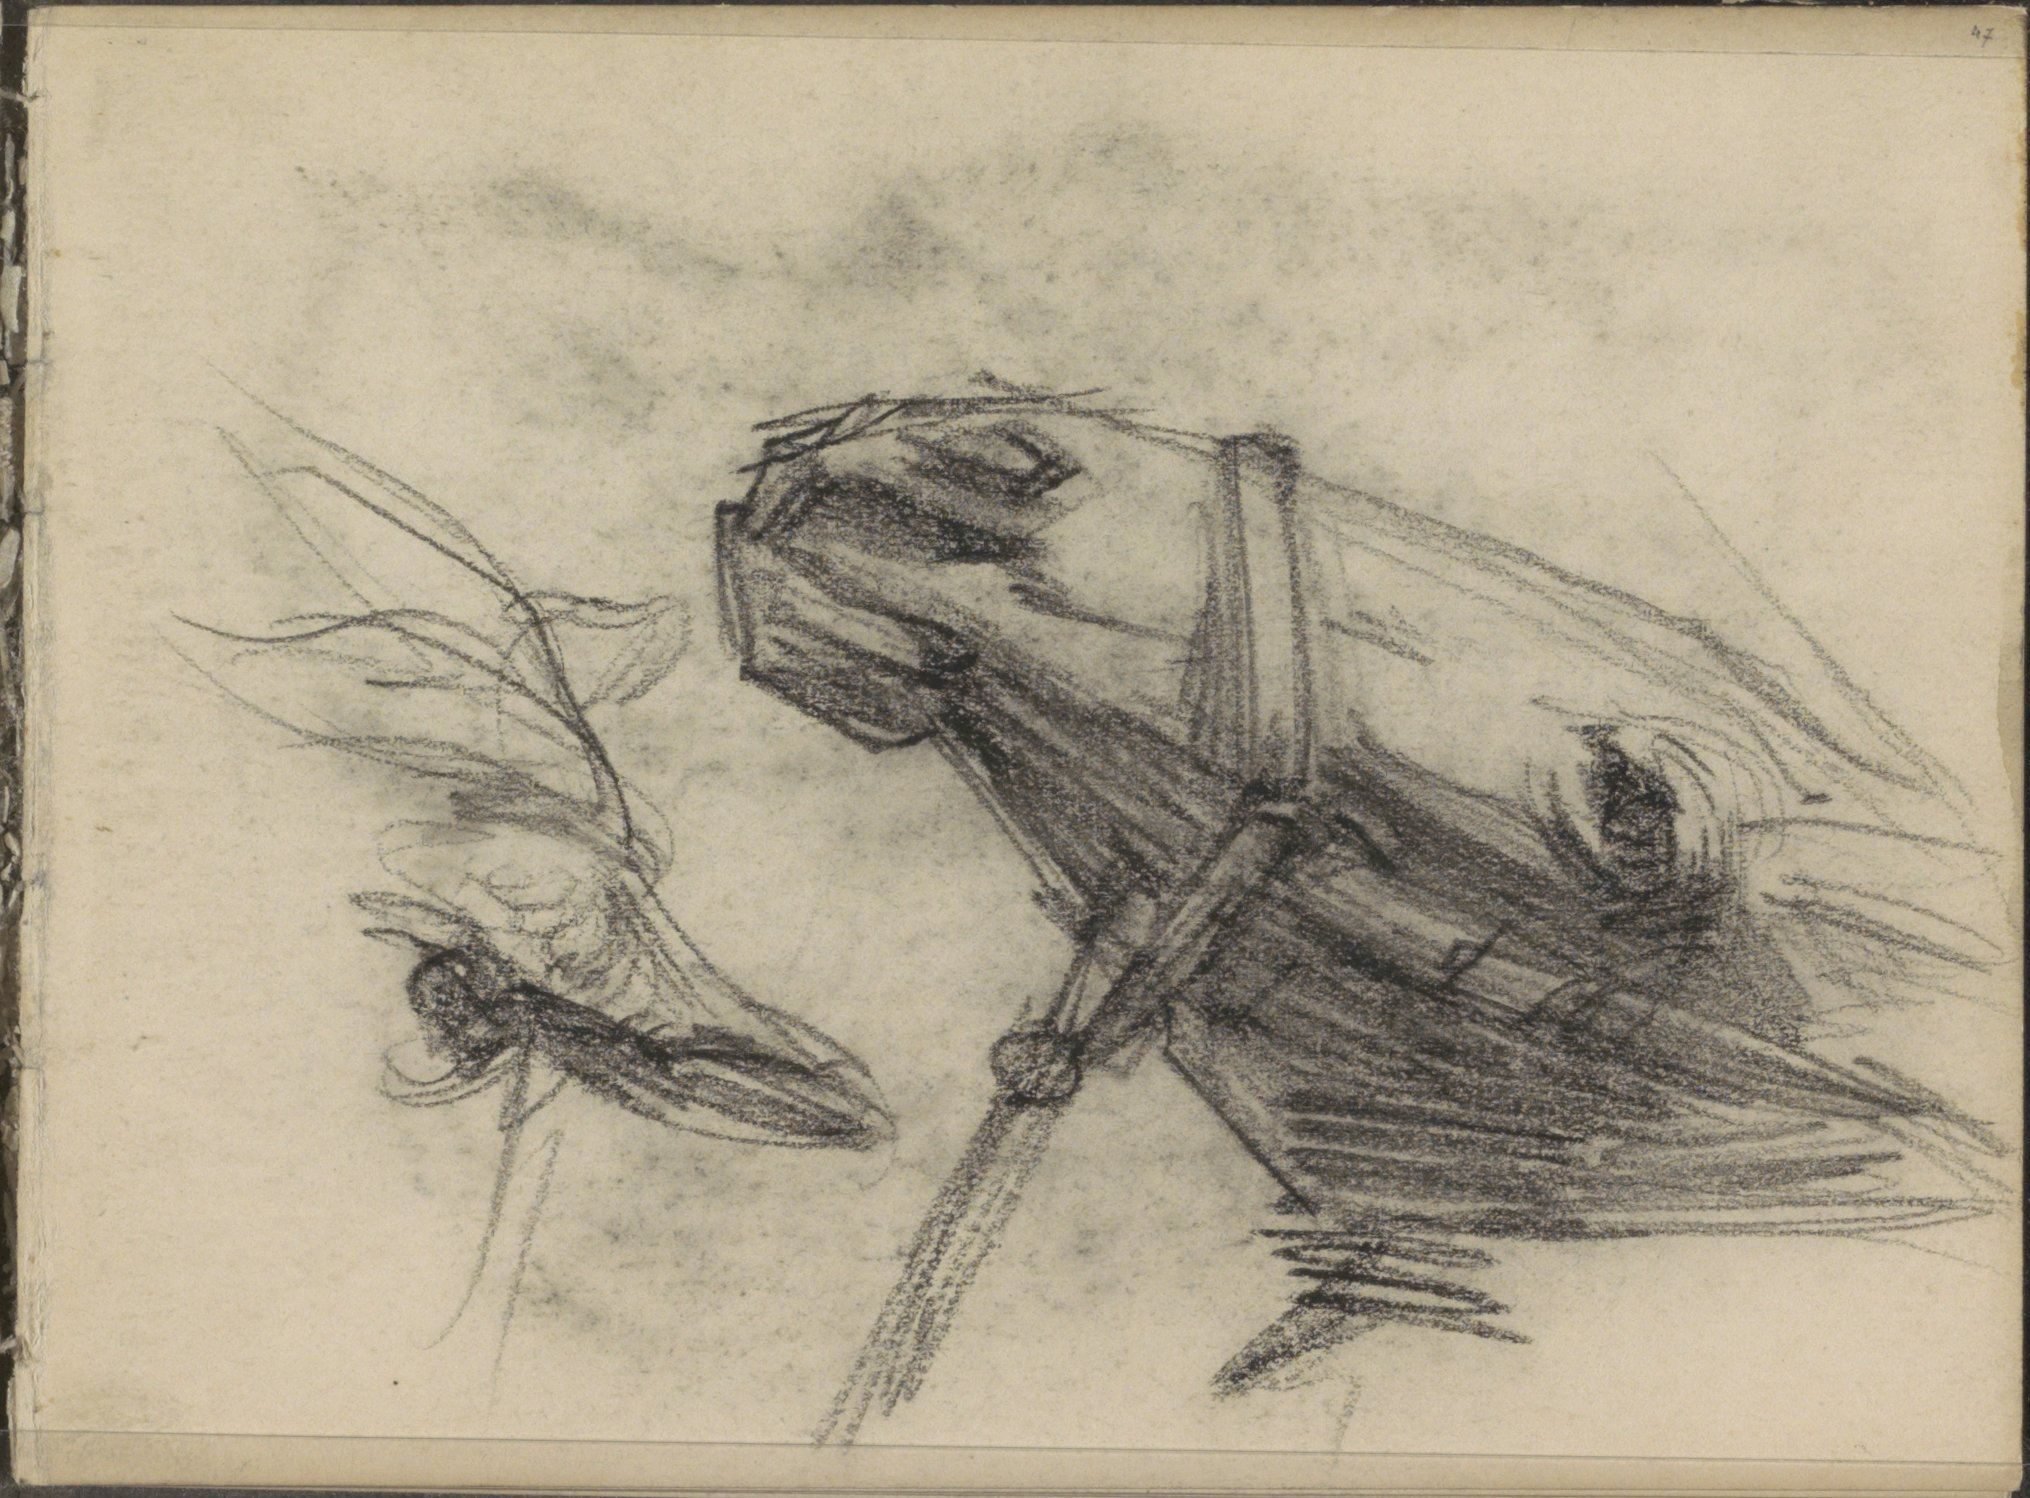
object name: sketchbook leaf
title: Paardenhoofd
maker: marius bauer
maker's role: draughtsman, print maker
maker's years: 1867-1932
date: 1879-1884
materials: chalk, paper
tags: horse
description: Tevens een studie van paardenoren. Pagina 47 uit een schetsboek met 28 bladen.